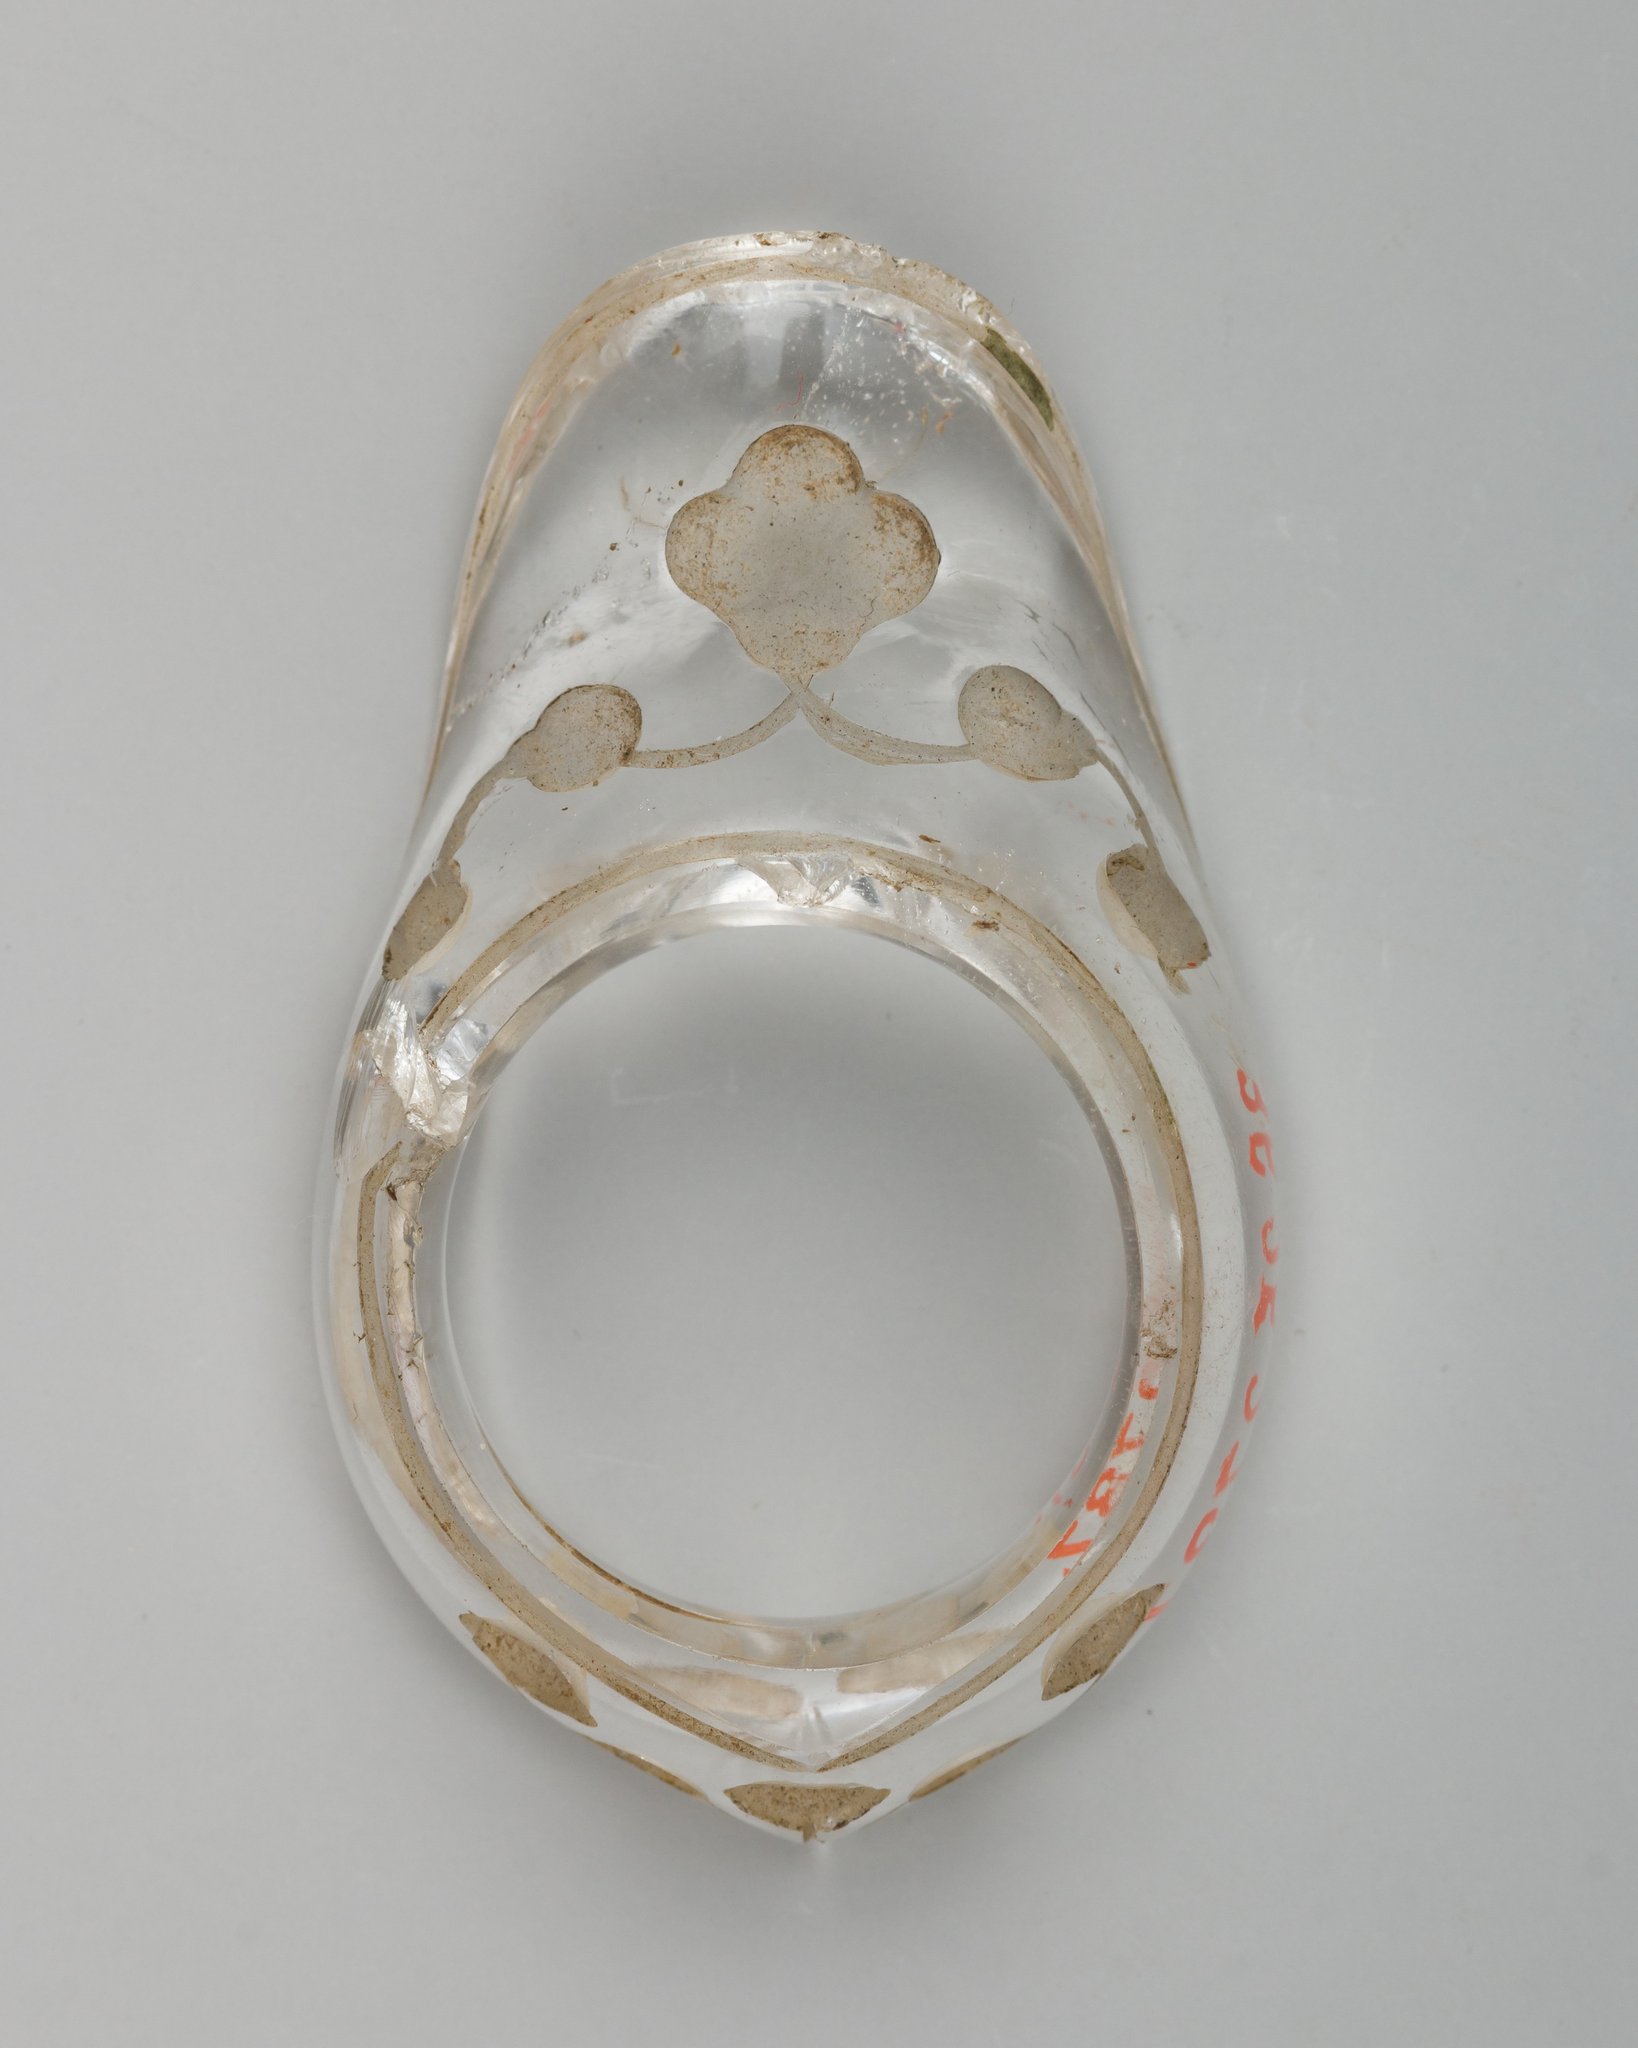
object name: archer's ring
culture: indian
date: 1601-1800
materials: crystal, gold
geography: india